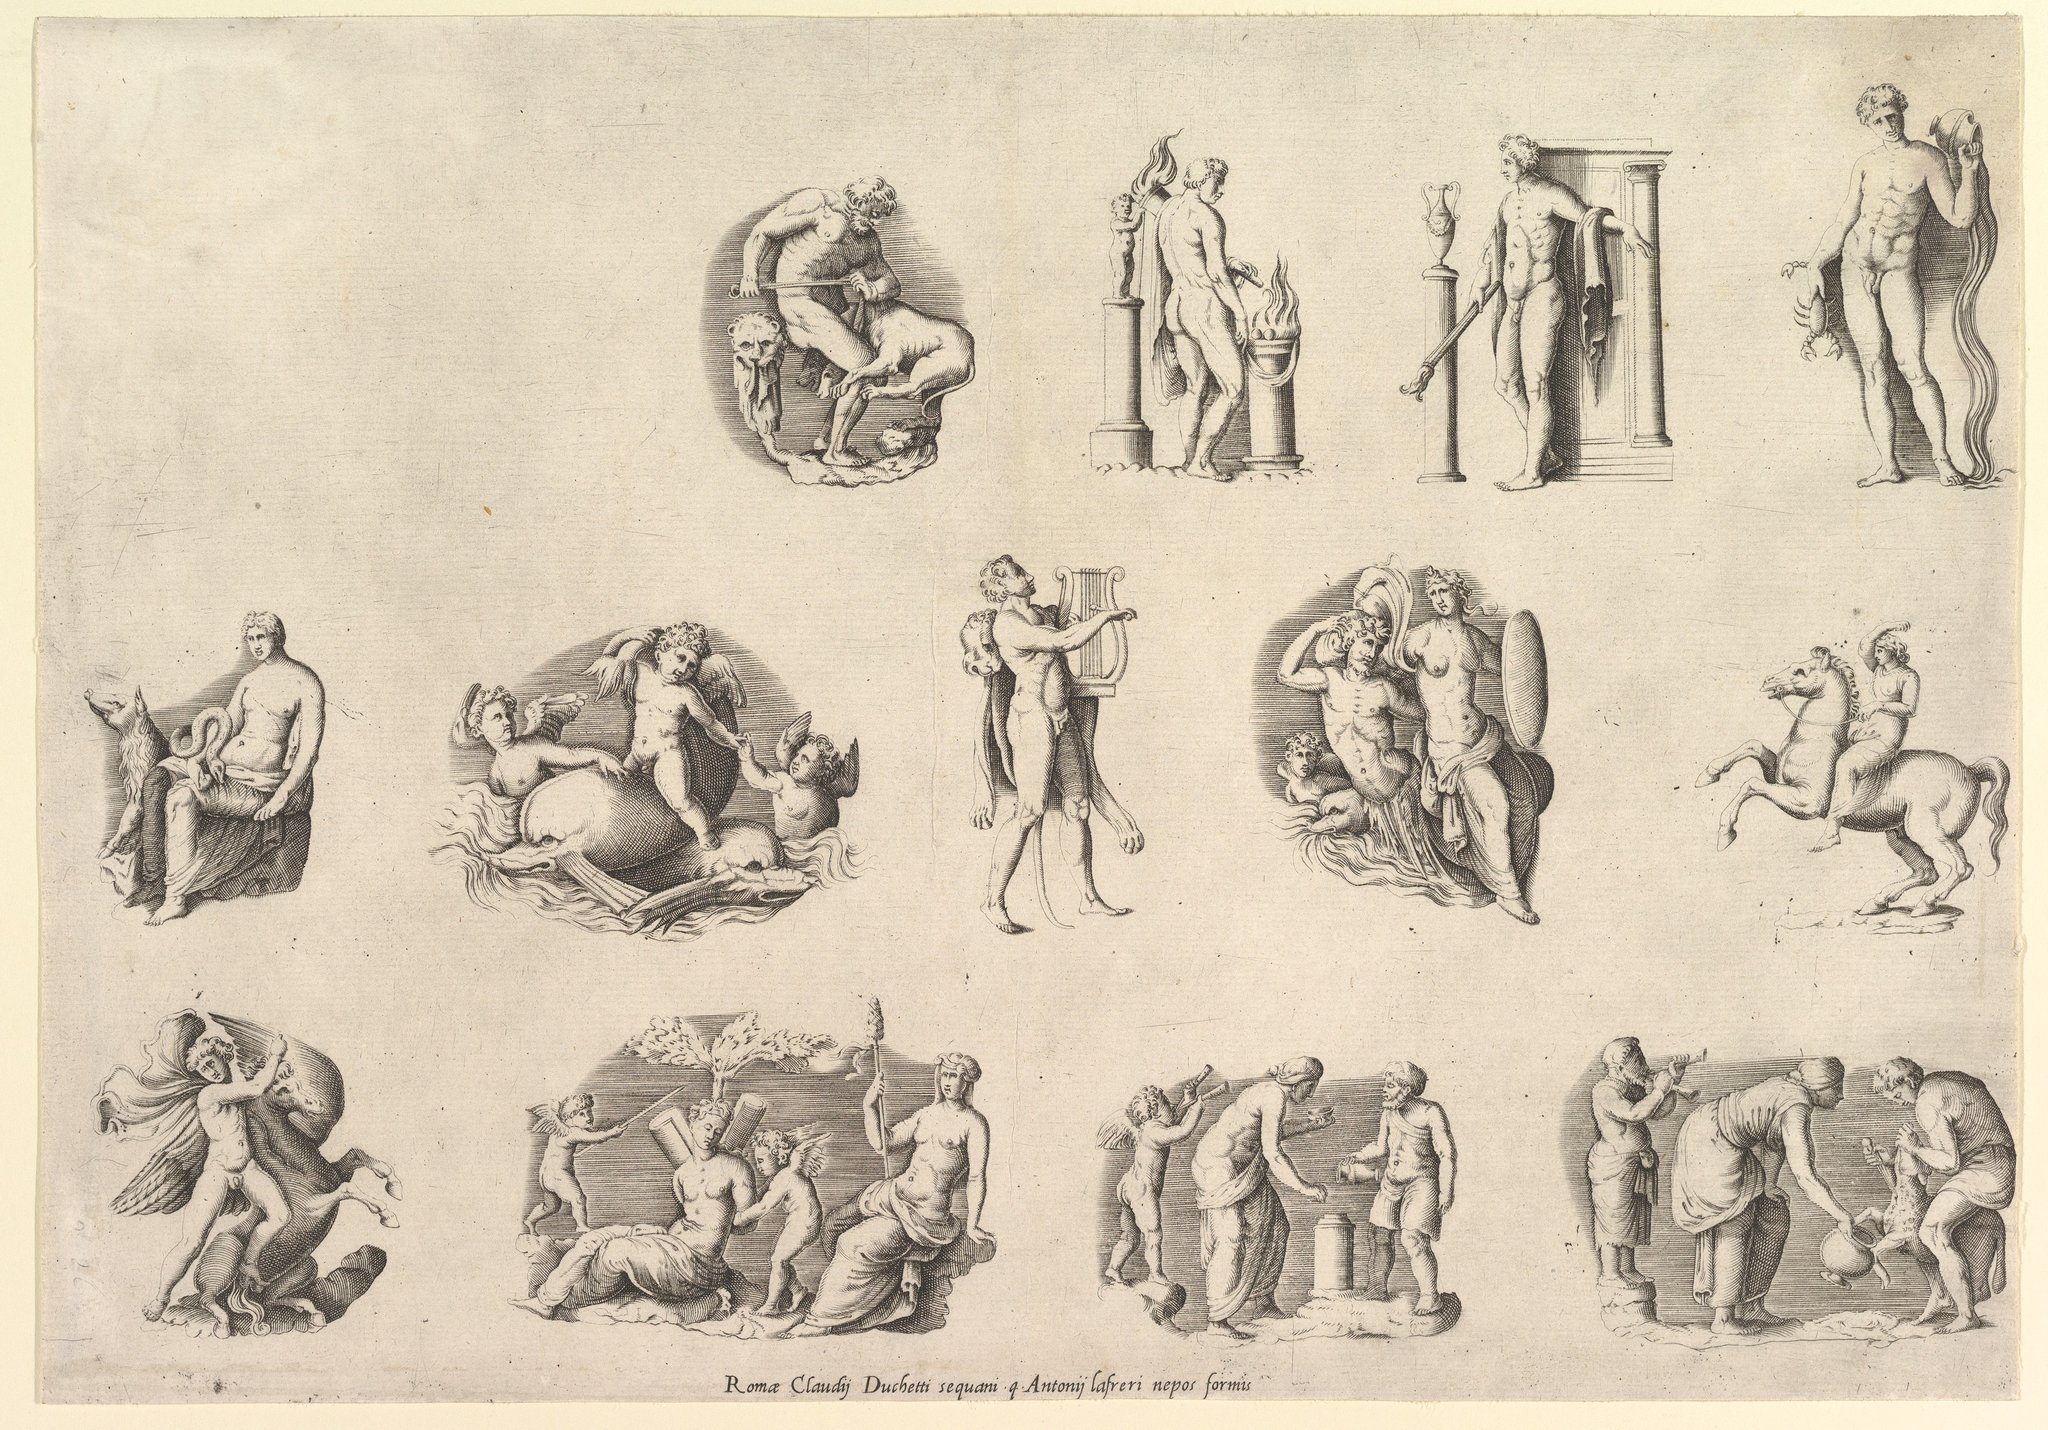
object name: print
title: Subjects after Antique Cameos and Gems, from "Speculum Romanae Magnificentiae"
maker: anonymous, italian, 16th century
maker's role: artist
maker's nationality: italian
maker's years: 1500-1600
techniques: engraving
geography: rome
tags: male nudes,female nudes,cupid,horses